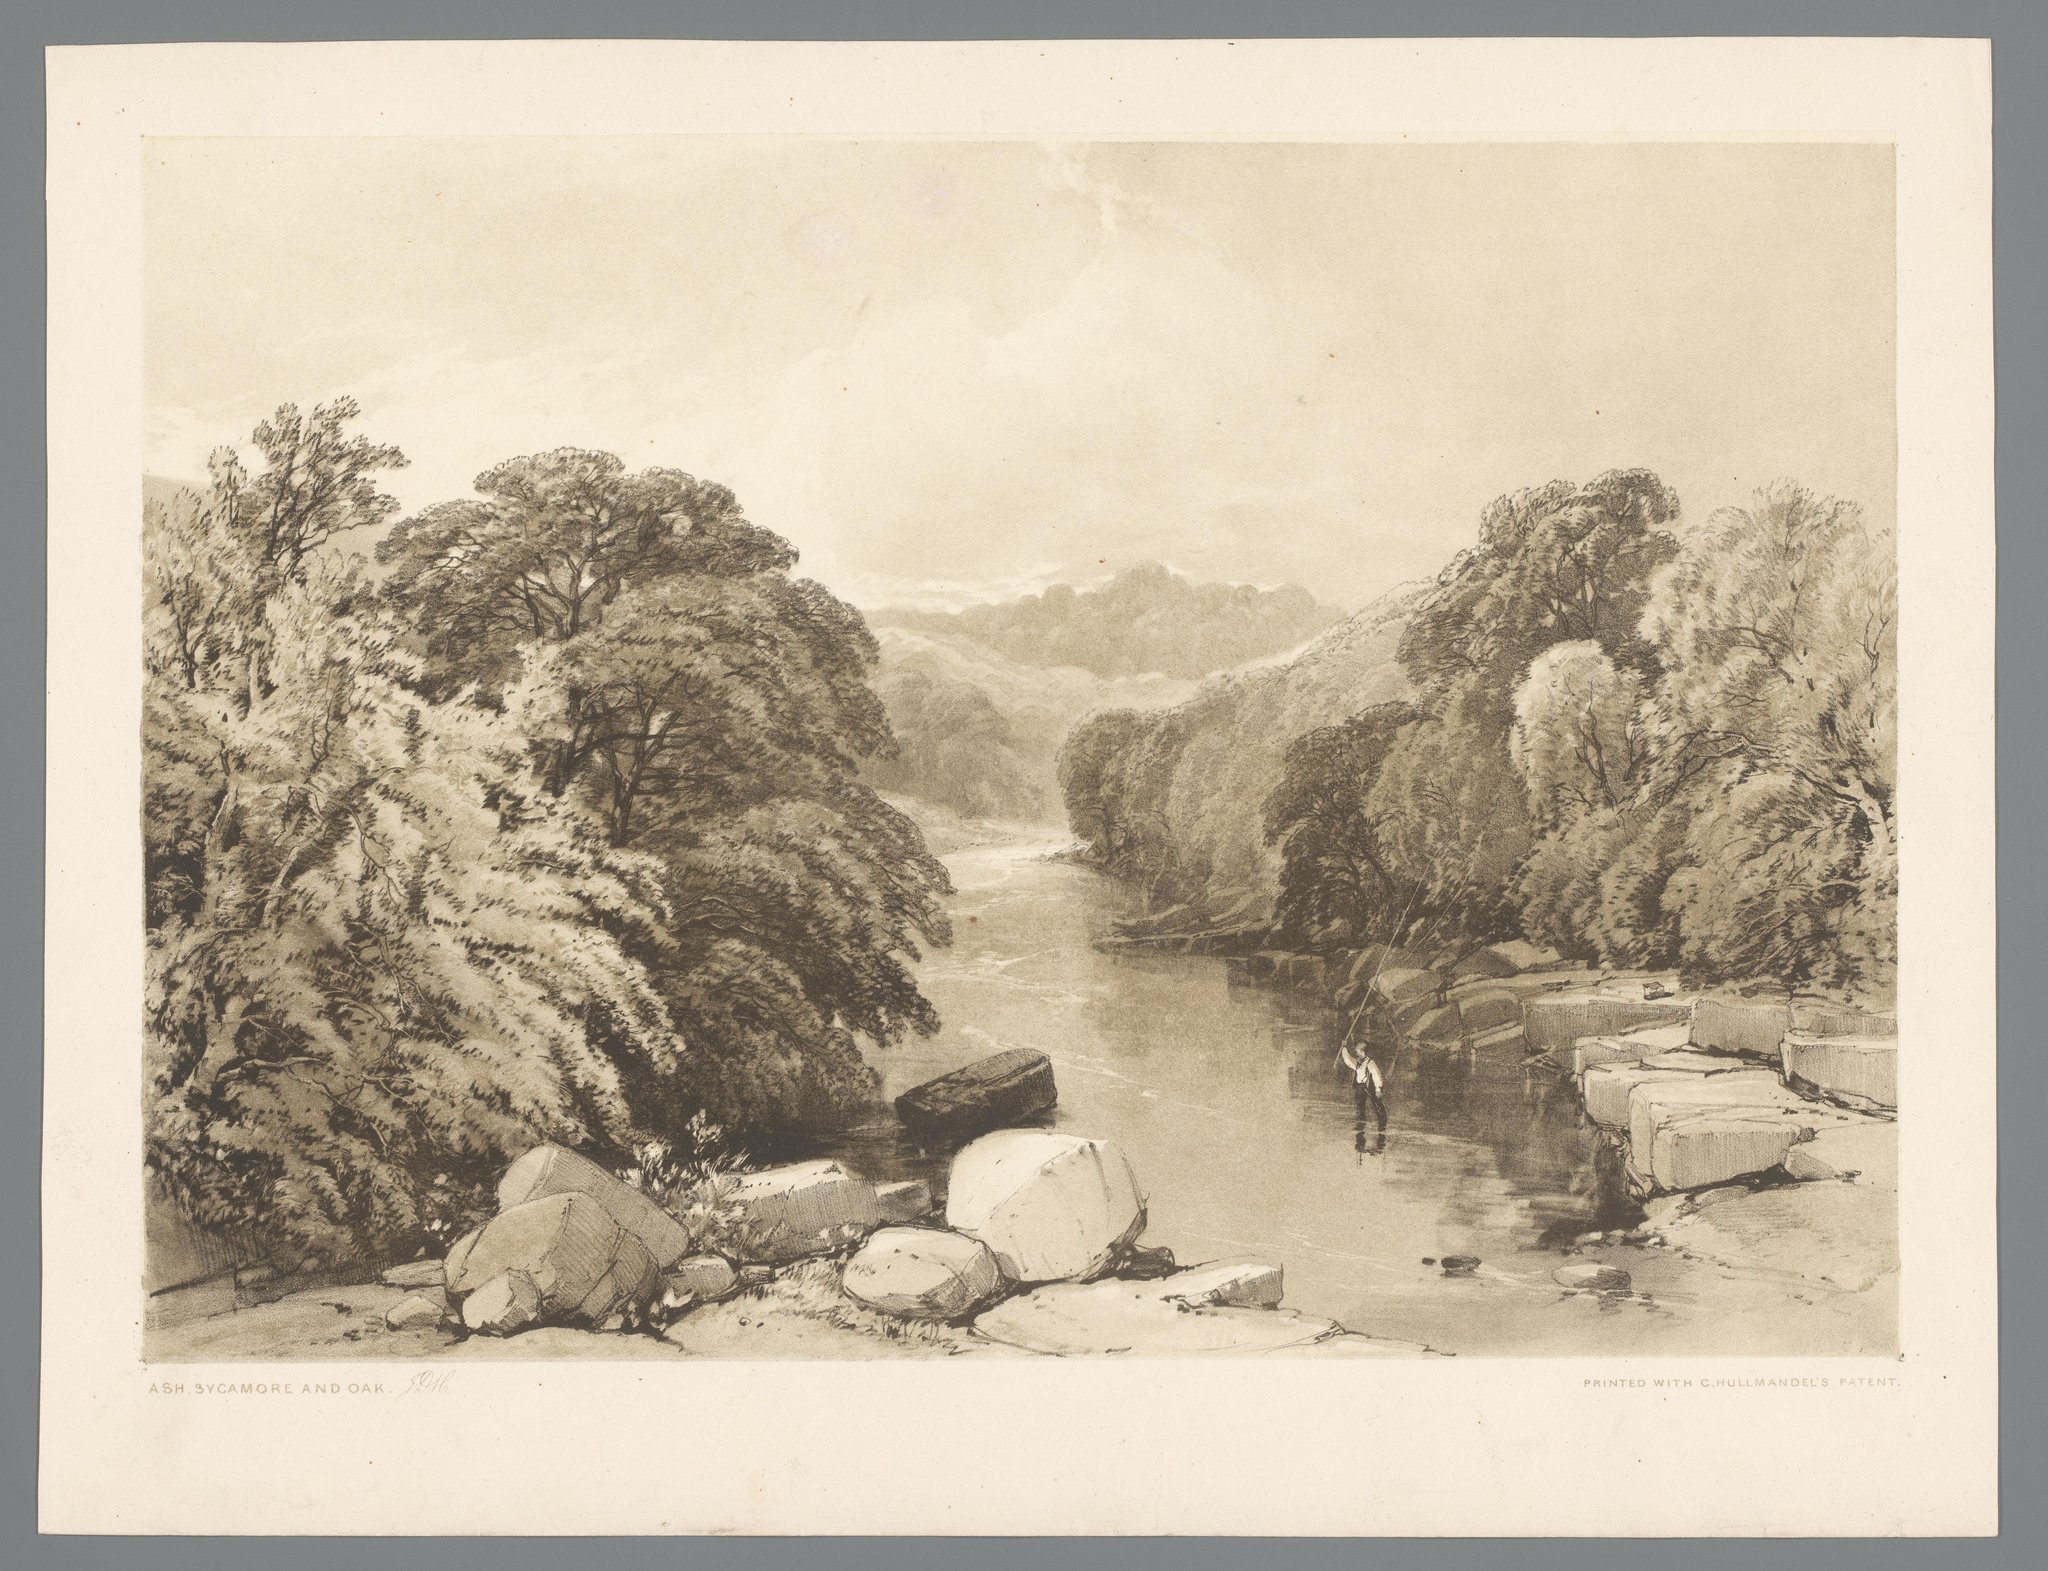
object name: print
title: The Park and the Forest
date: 1841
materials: paper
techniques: tone lithography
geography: london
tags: park, forest, wood, river (+ landscape with figures, staffage)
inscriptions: collector's mark: Lugt 2228, collector's mark: Lugt 2760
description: Prent maakt deel uit van een serie van 24 prenten.